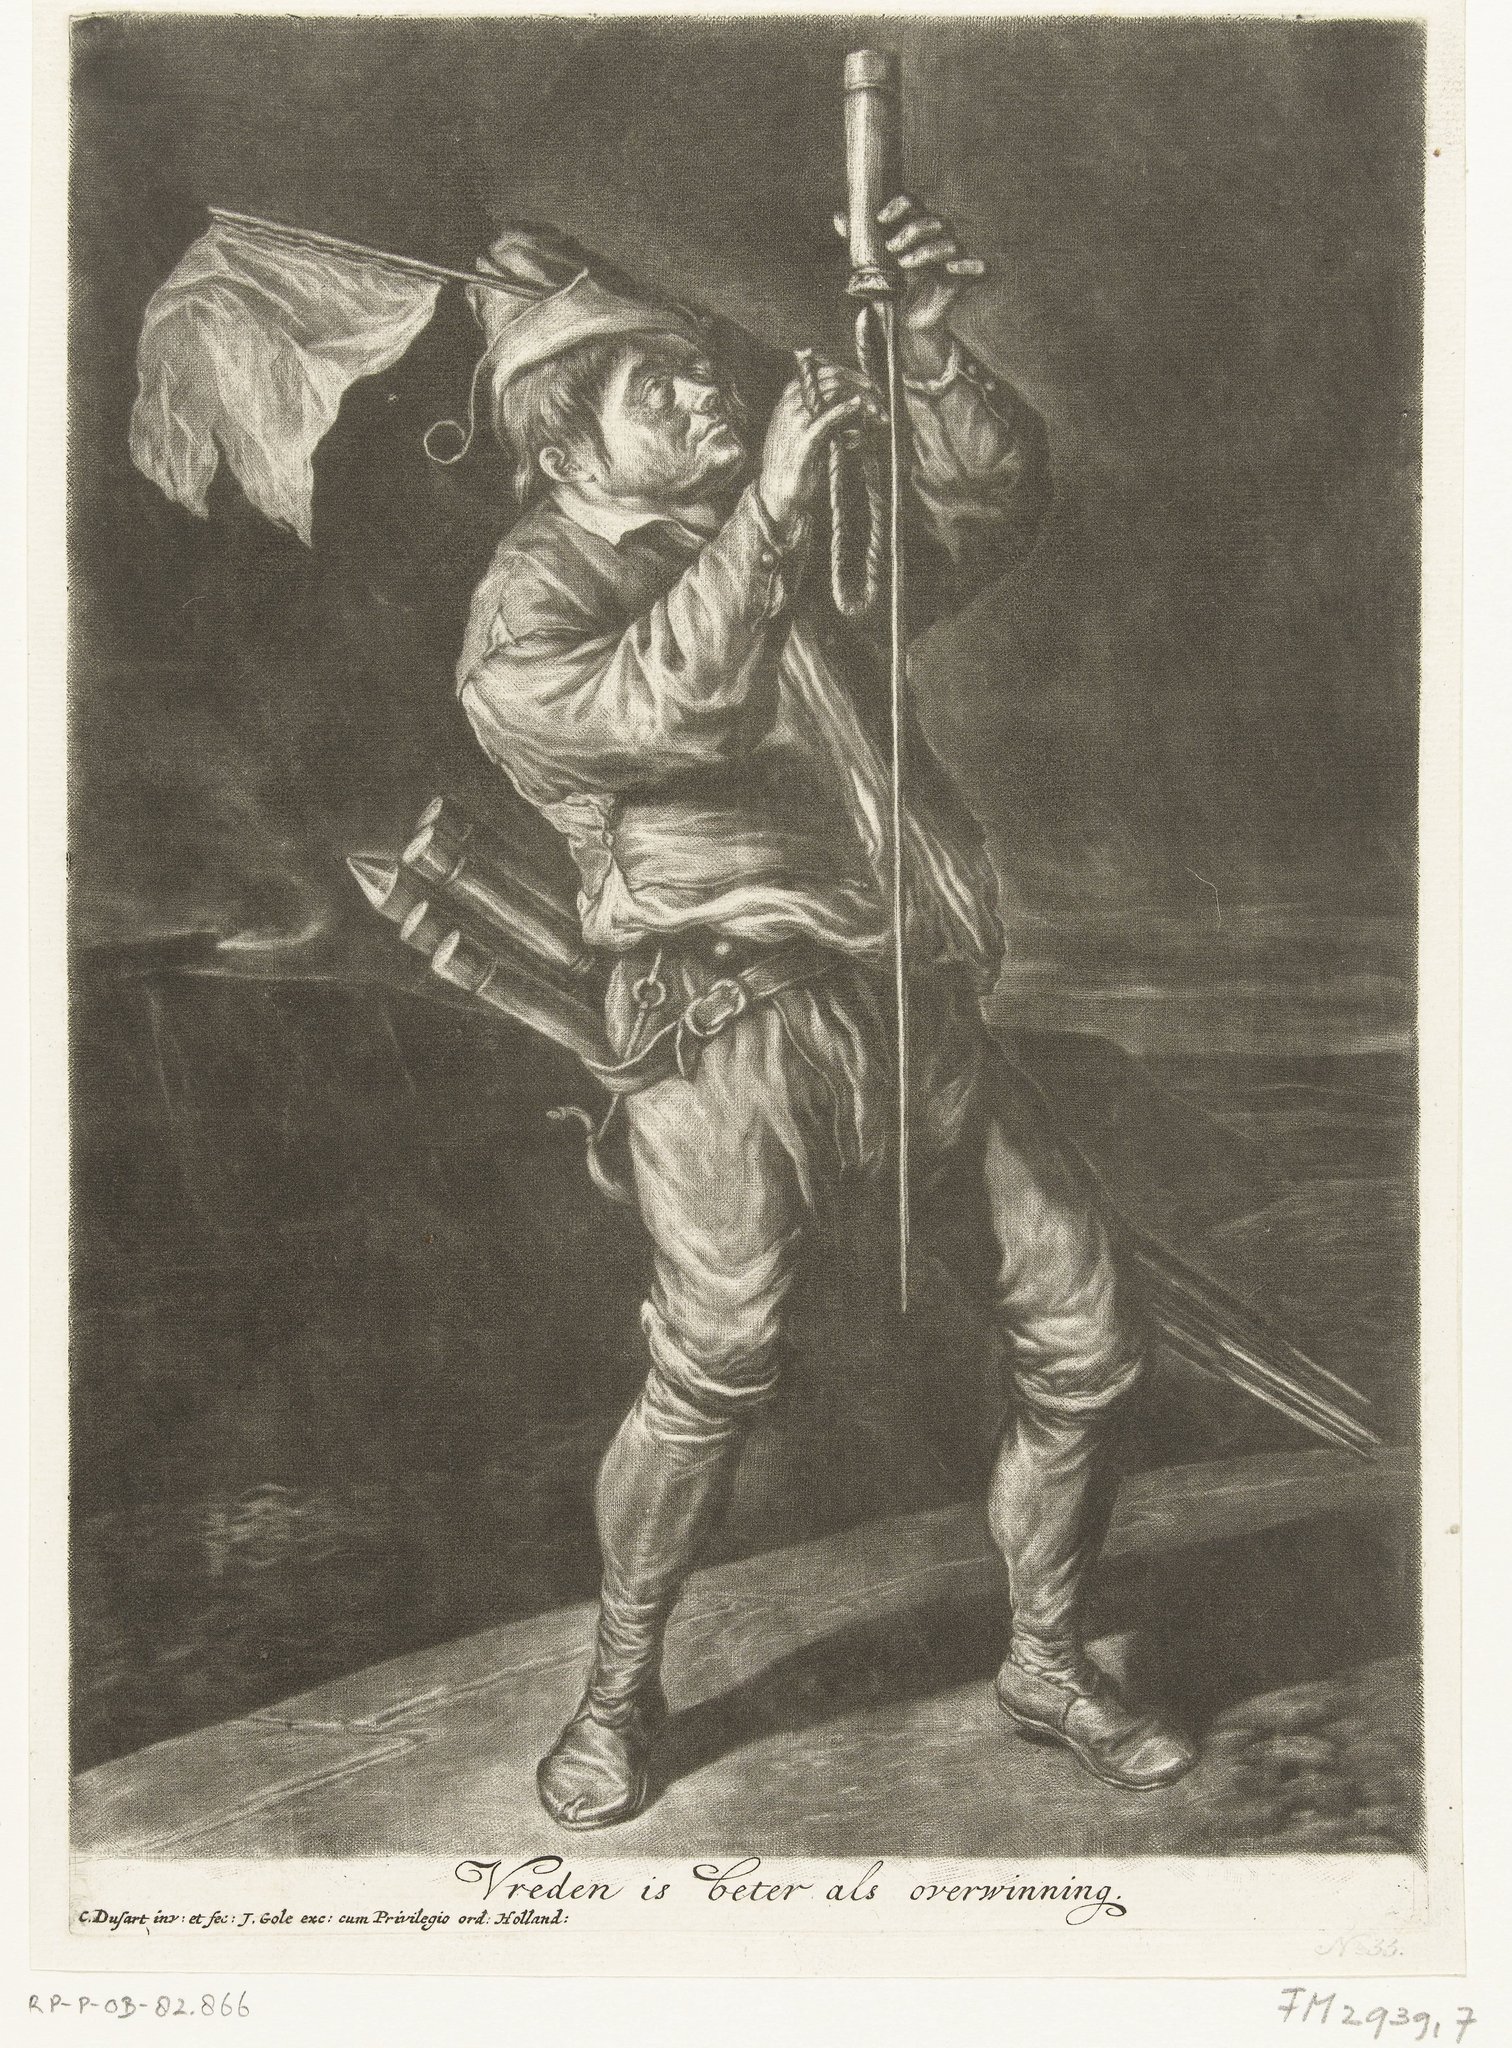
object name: print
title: De algemene blijdschap om de inname van Namen door stadhouder Willem III, koning van Engeland, september 1695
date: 1695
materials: paper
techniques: mezzotint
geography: northern netherlands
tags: the hague, william iii (prince of orange and king of england, scotland, and ireland), bonfire, fire-works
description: Een man steekt met een lont een vuurpijl aan. Onderdeel van een reeks van acht prenten vervaardigd naar aanleiding van de verovering van Namen door de geallieerden onder koning Willem III op 5 september 1695.